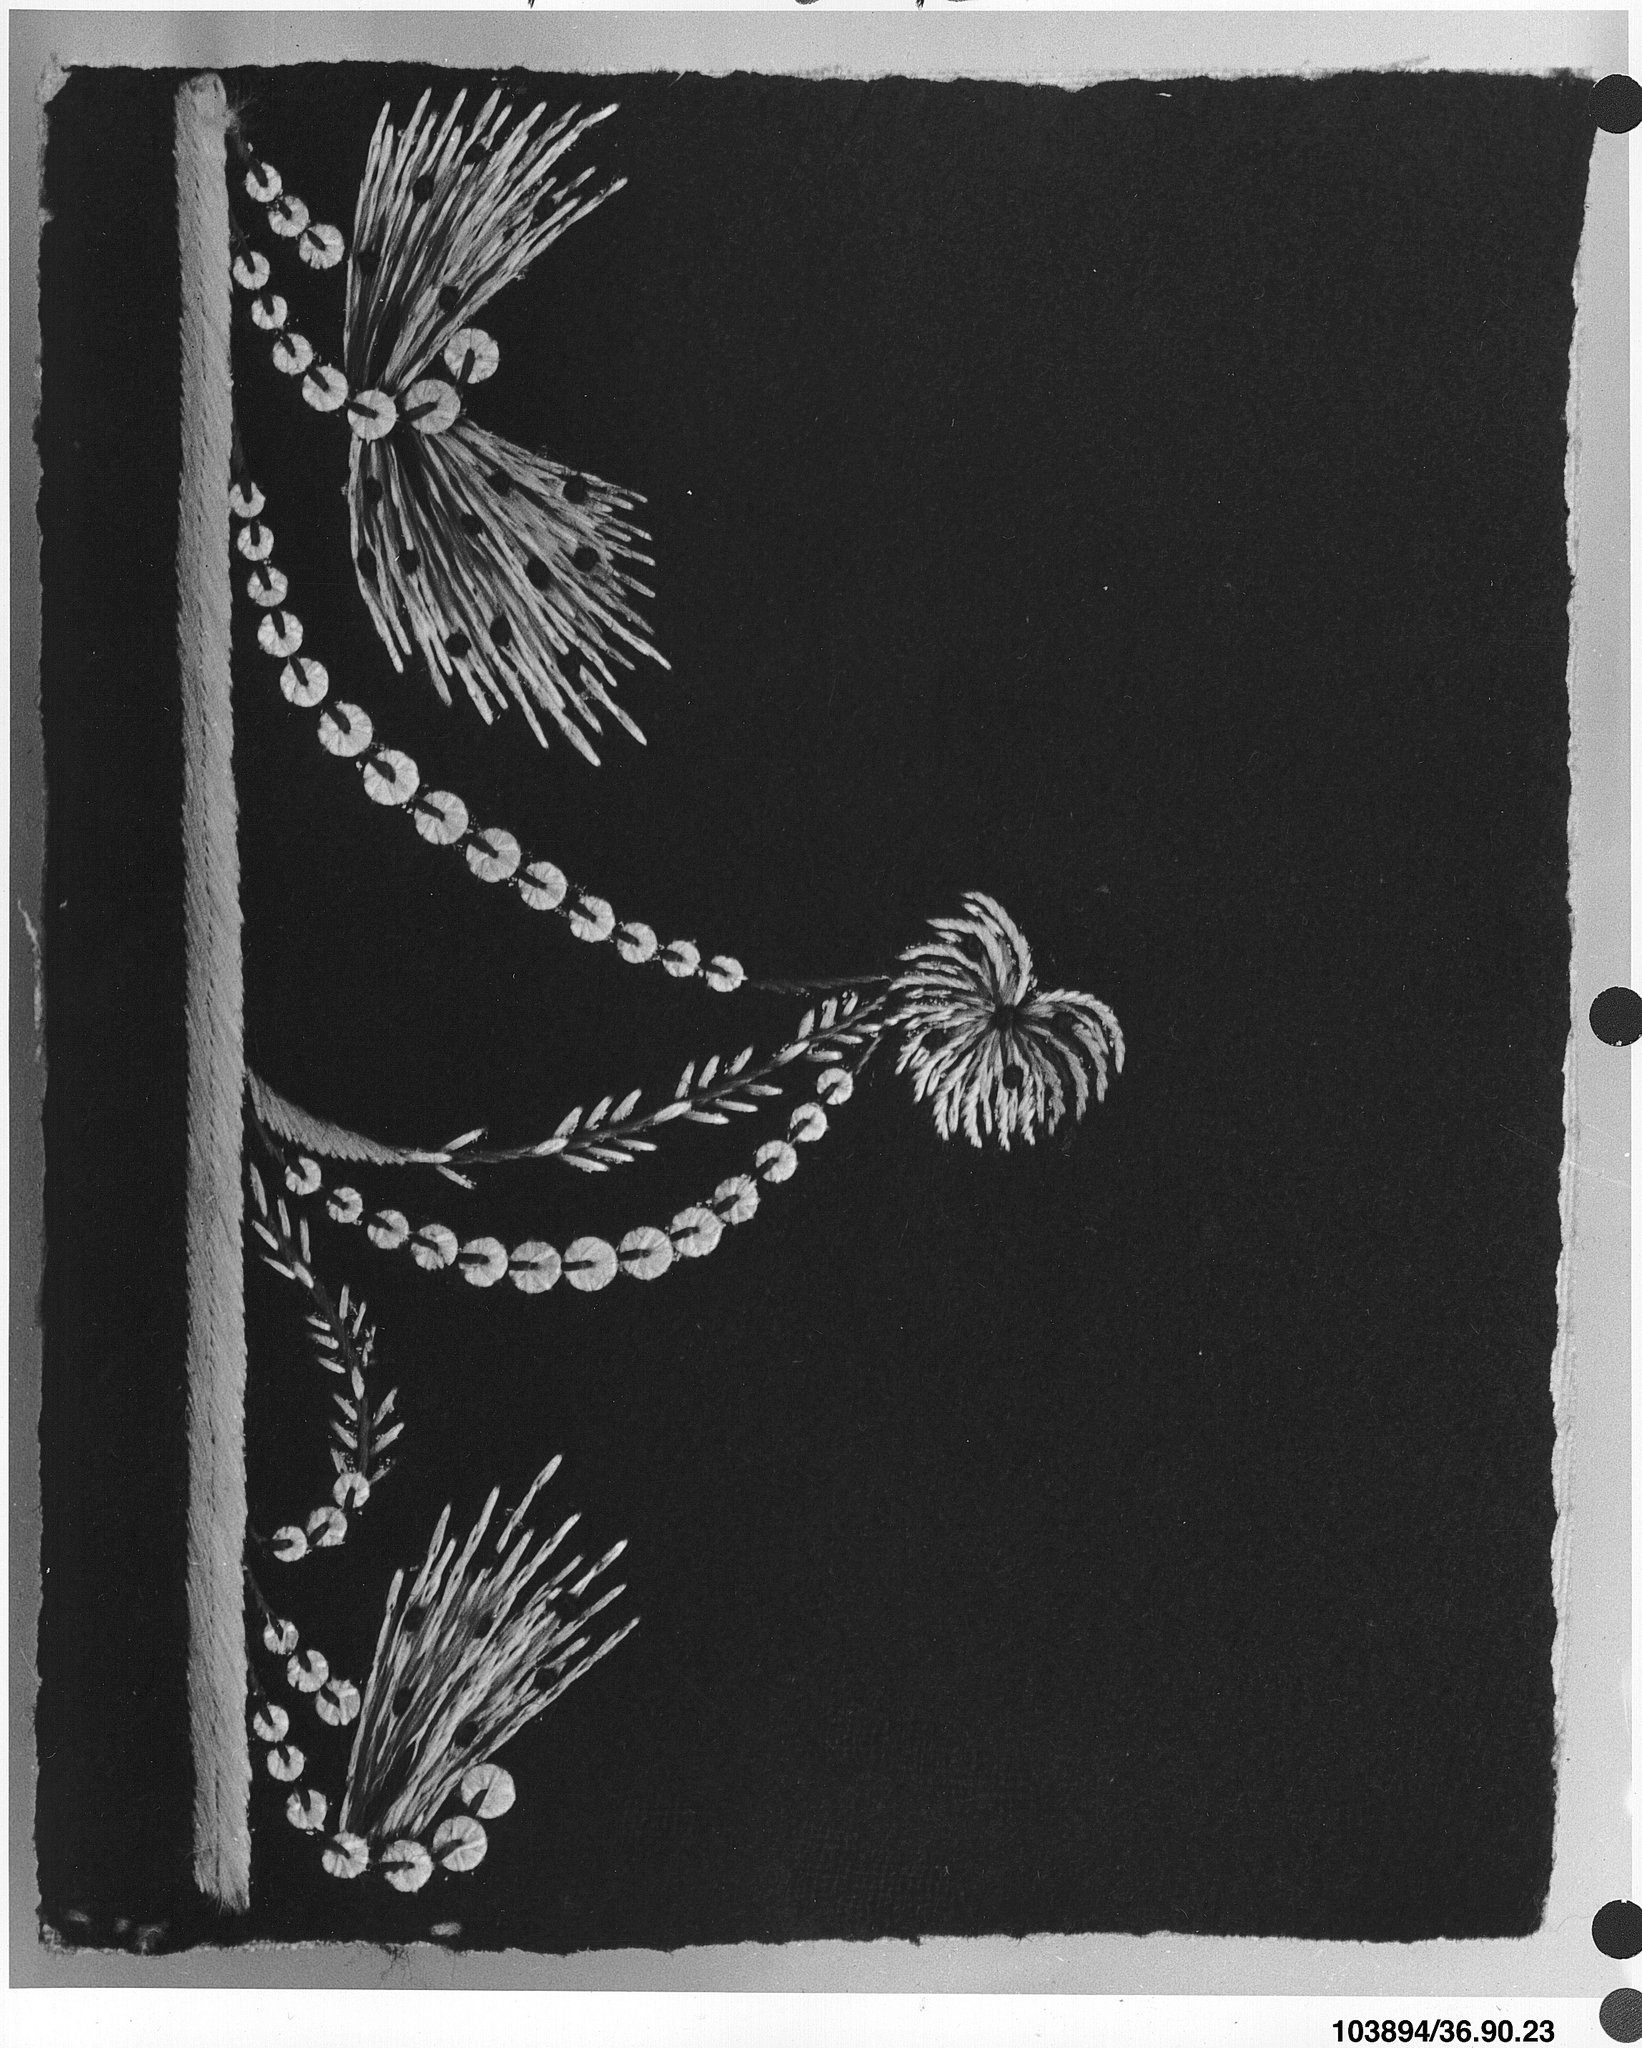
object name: sample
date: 1801-1833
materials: cardboard, silk, wool